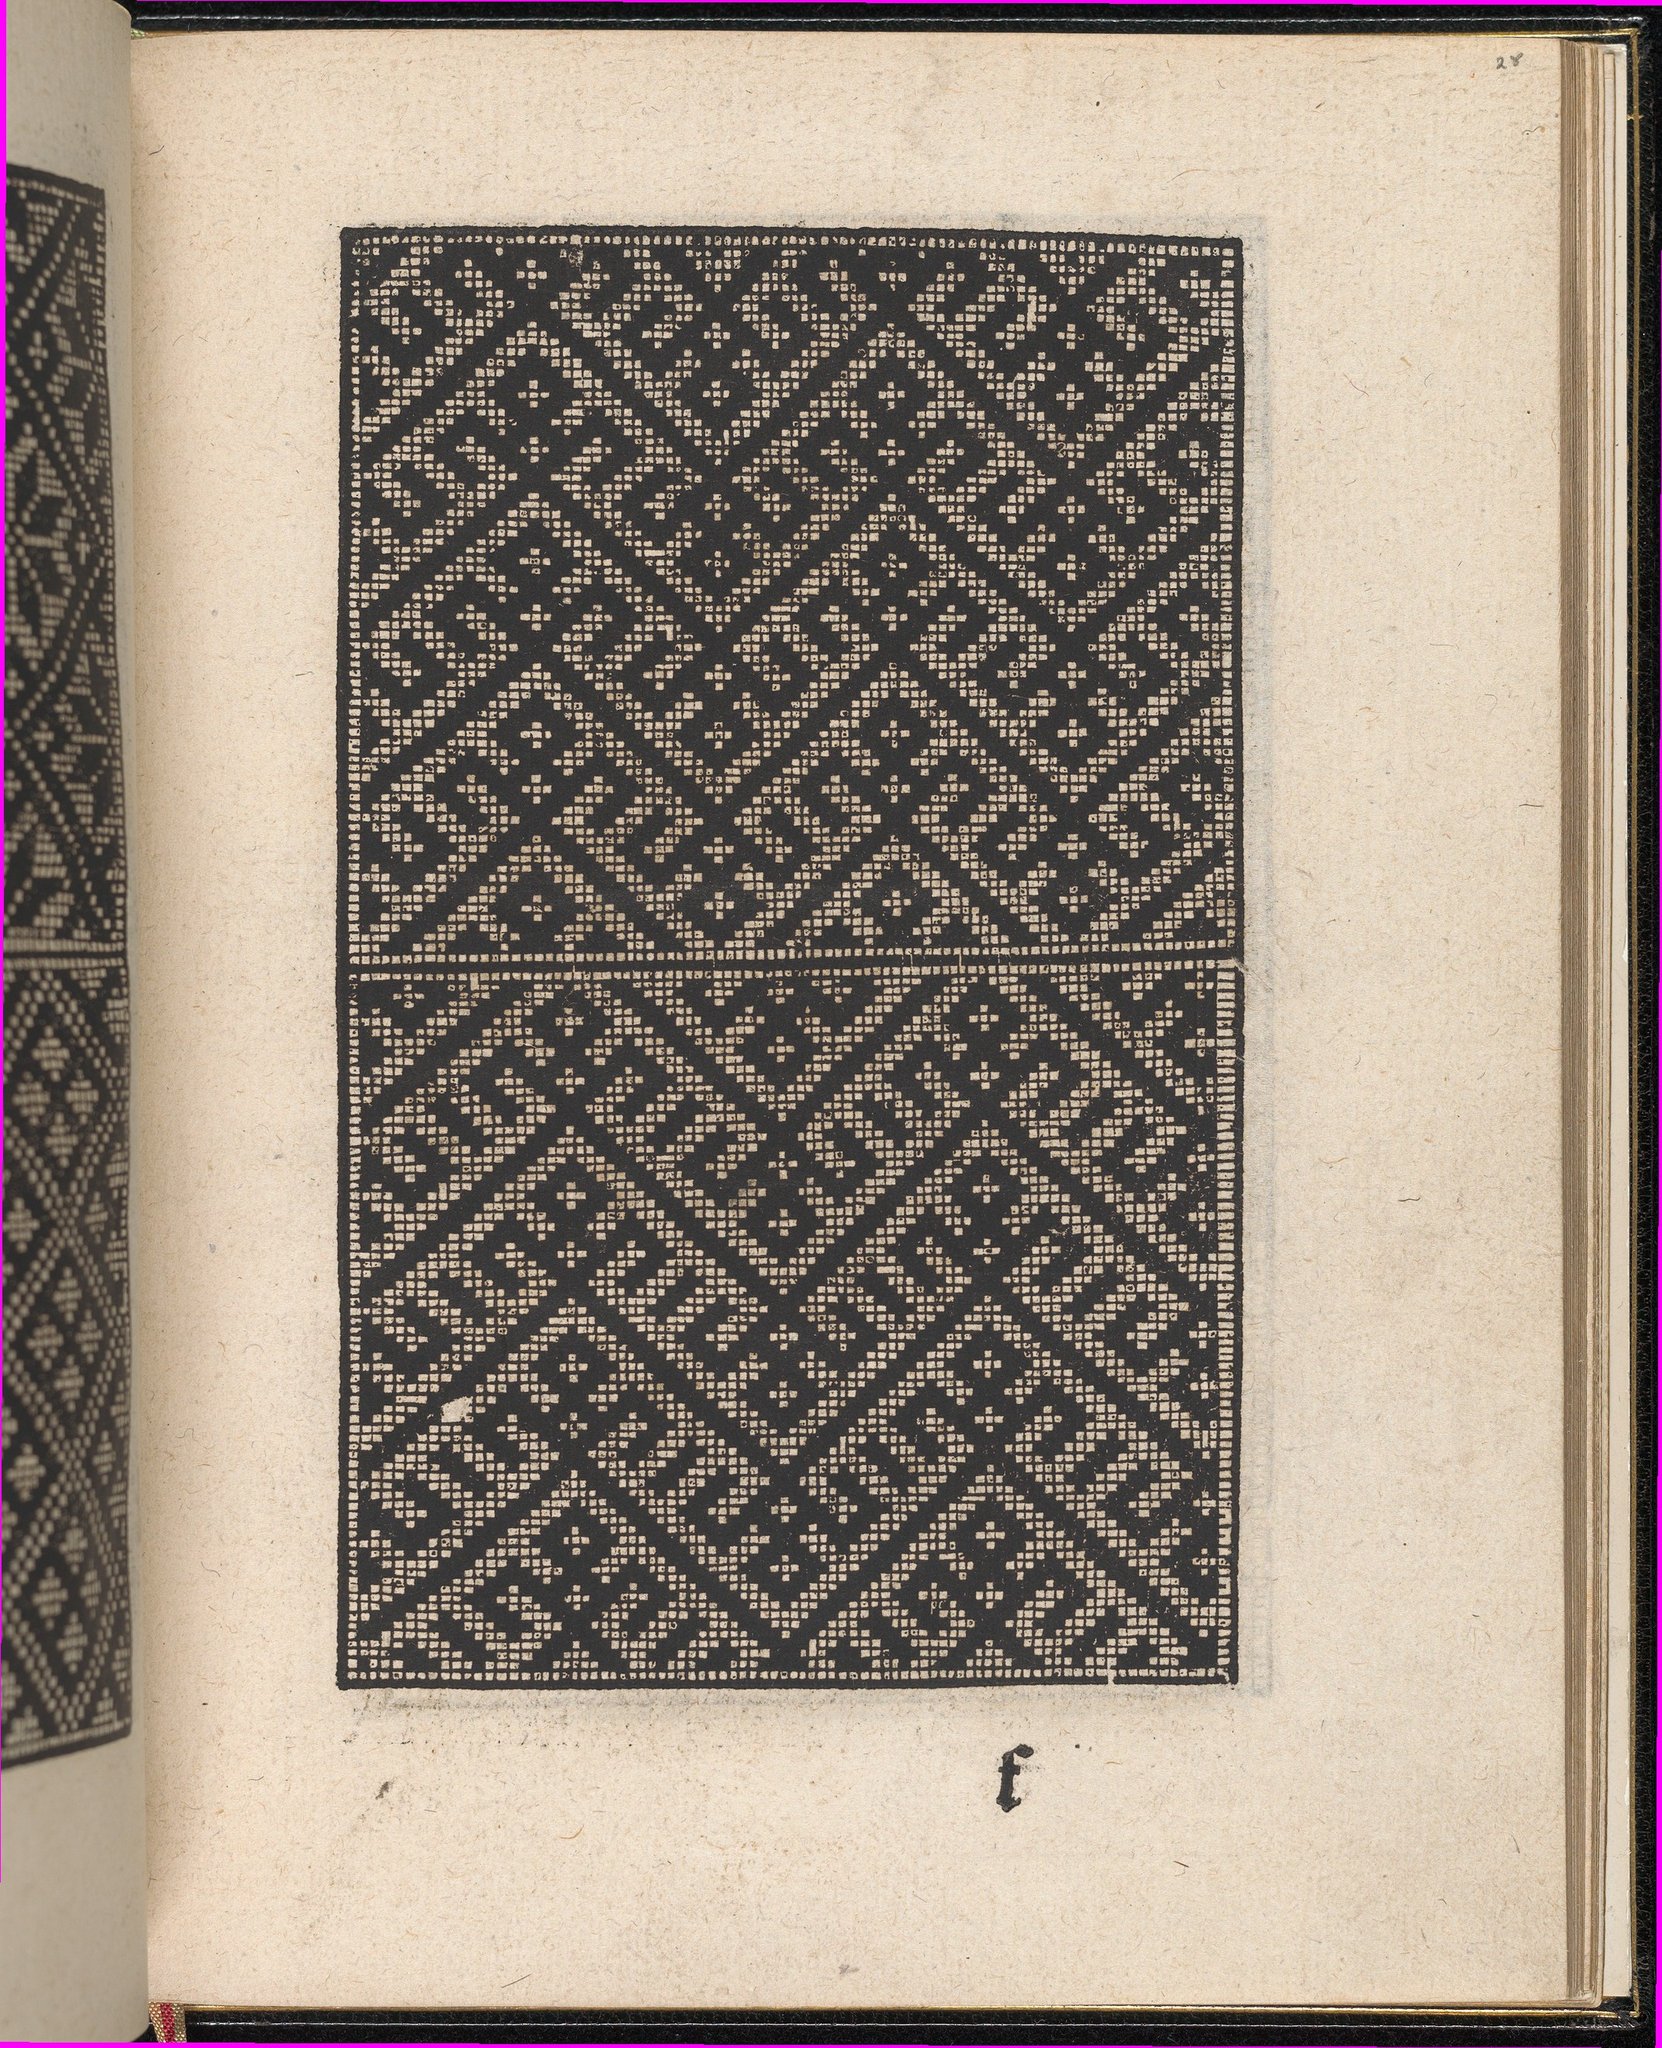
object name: book print ornament architecture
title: Page from Ein new kunstlich Modelbuch...(Page 28r)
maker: peter quentel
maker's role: publisher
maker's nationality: german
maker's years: 1500-1550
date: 1544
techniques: woodcut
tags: ornament